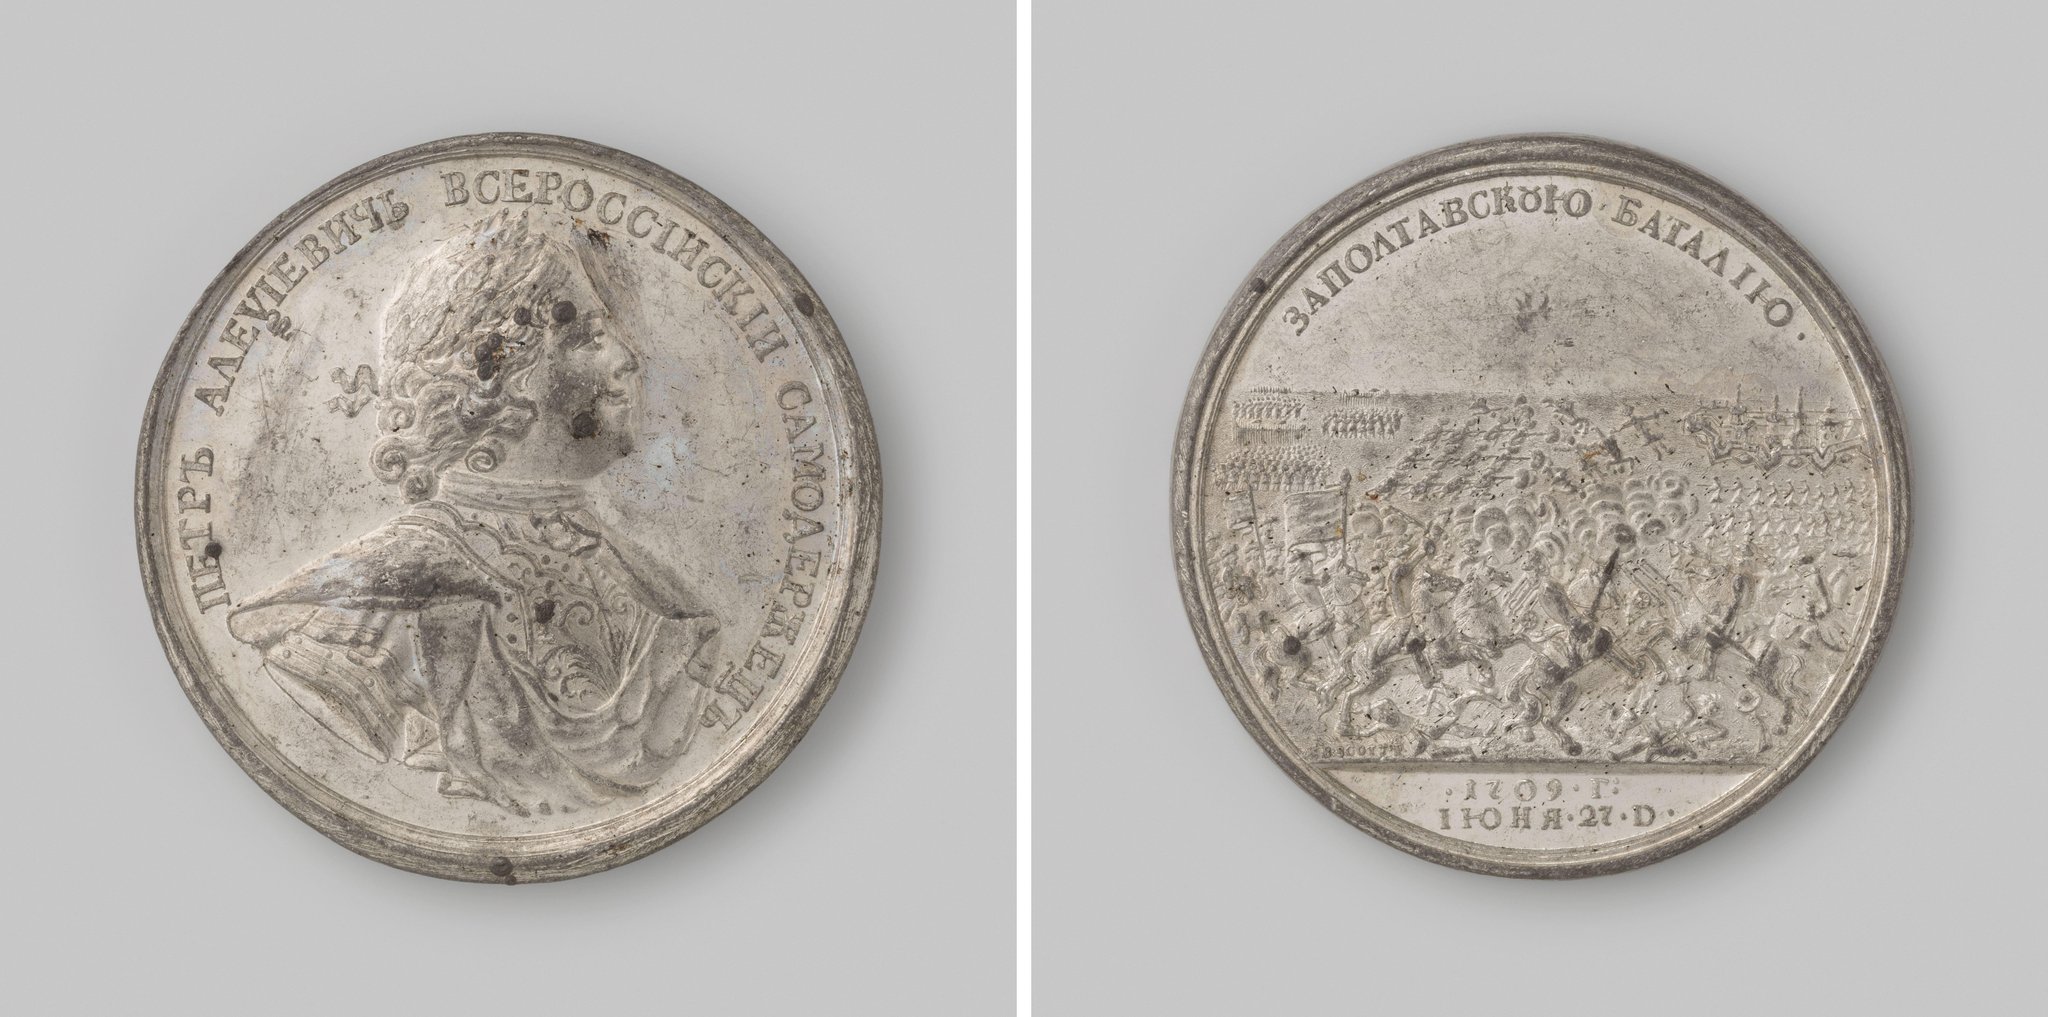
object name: history medal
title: Overwinning van Rusland op Zweden in de slag bij Pultawa 1709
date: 1709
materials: tin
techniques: striking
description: Tinnen penning, op de voorzijde het borstbeeld van Tsaar Peter de Grote naar rechts met omschrift, op de keerzijde het aanzicht van de veldslag met omschrift en afsnedetekst.